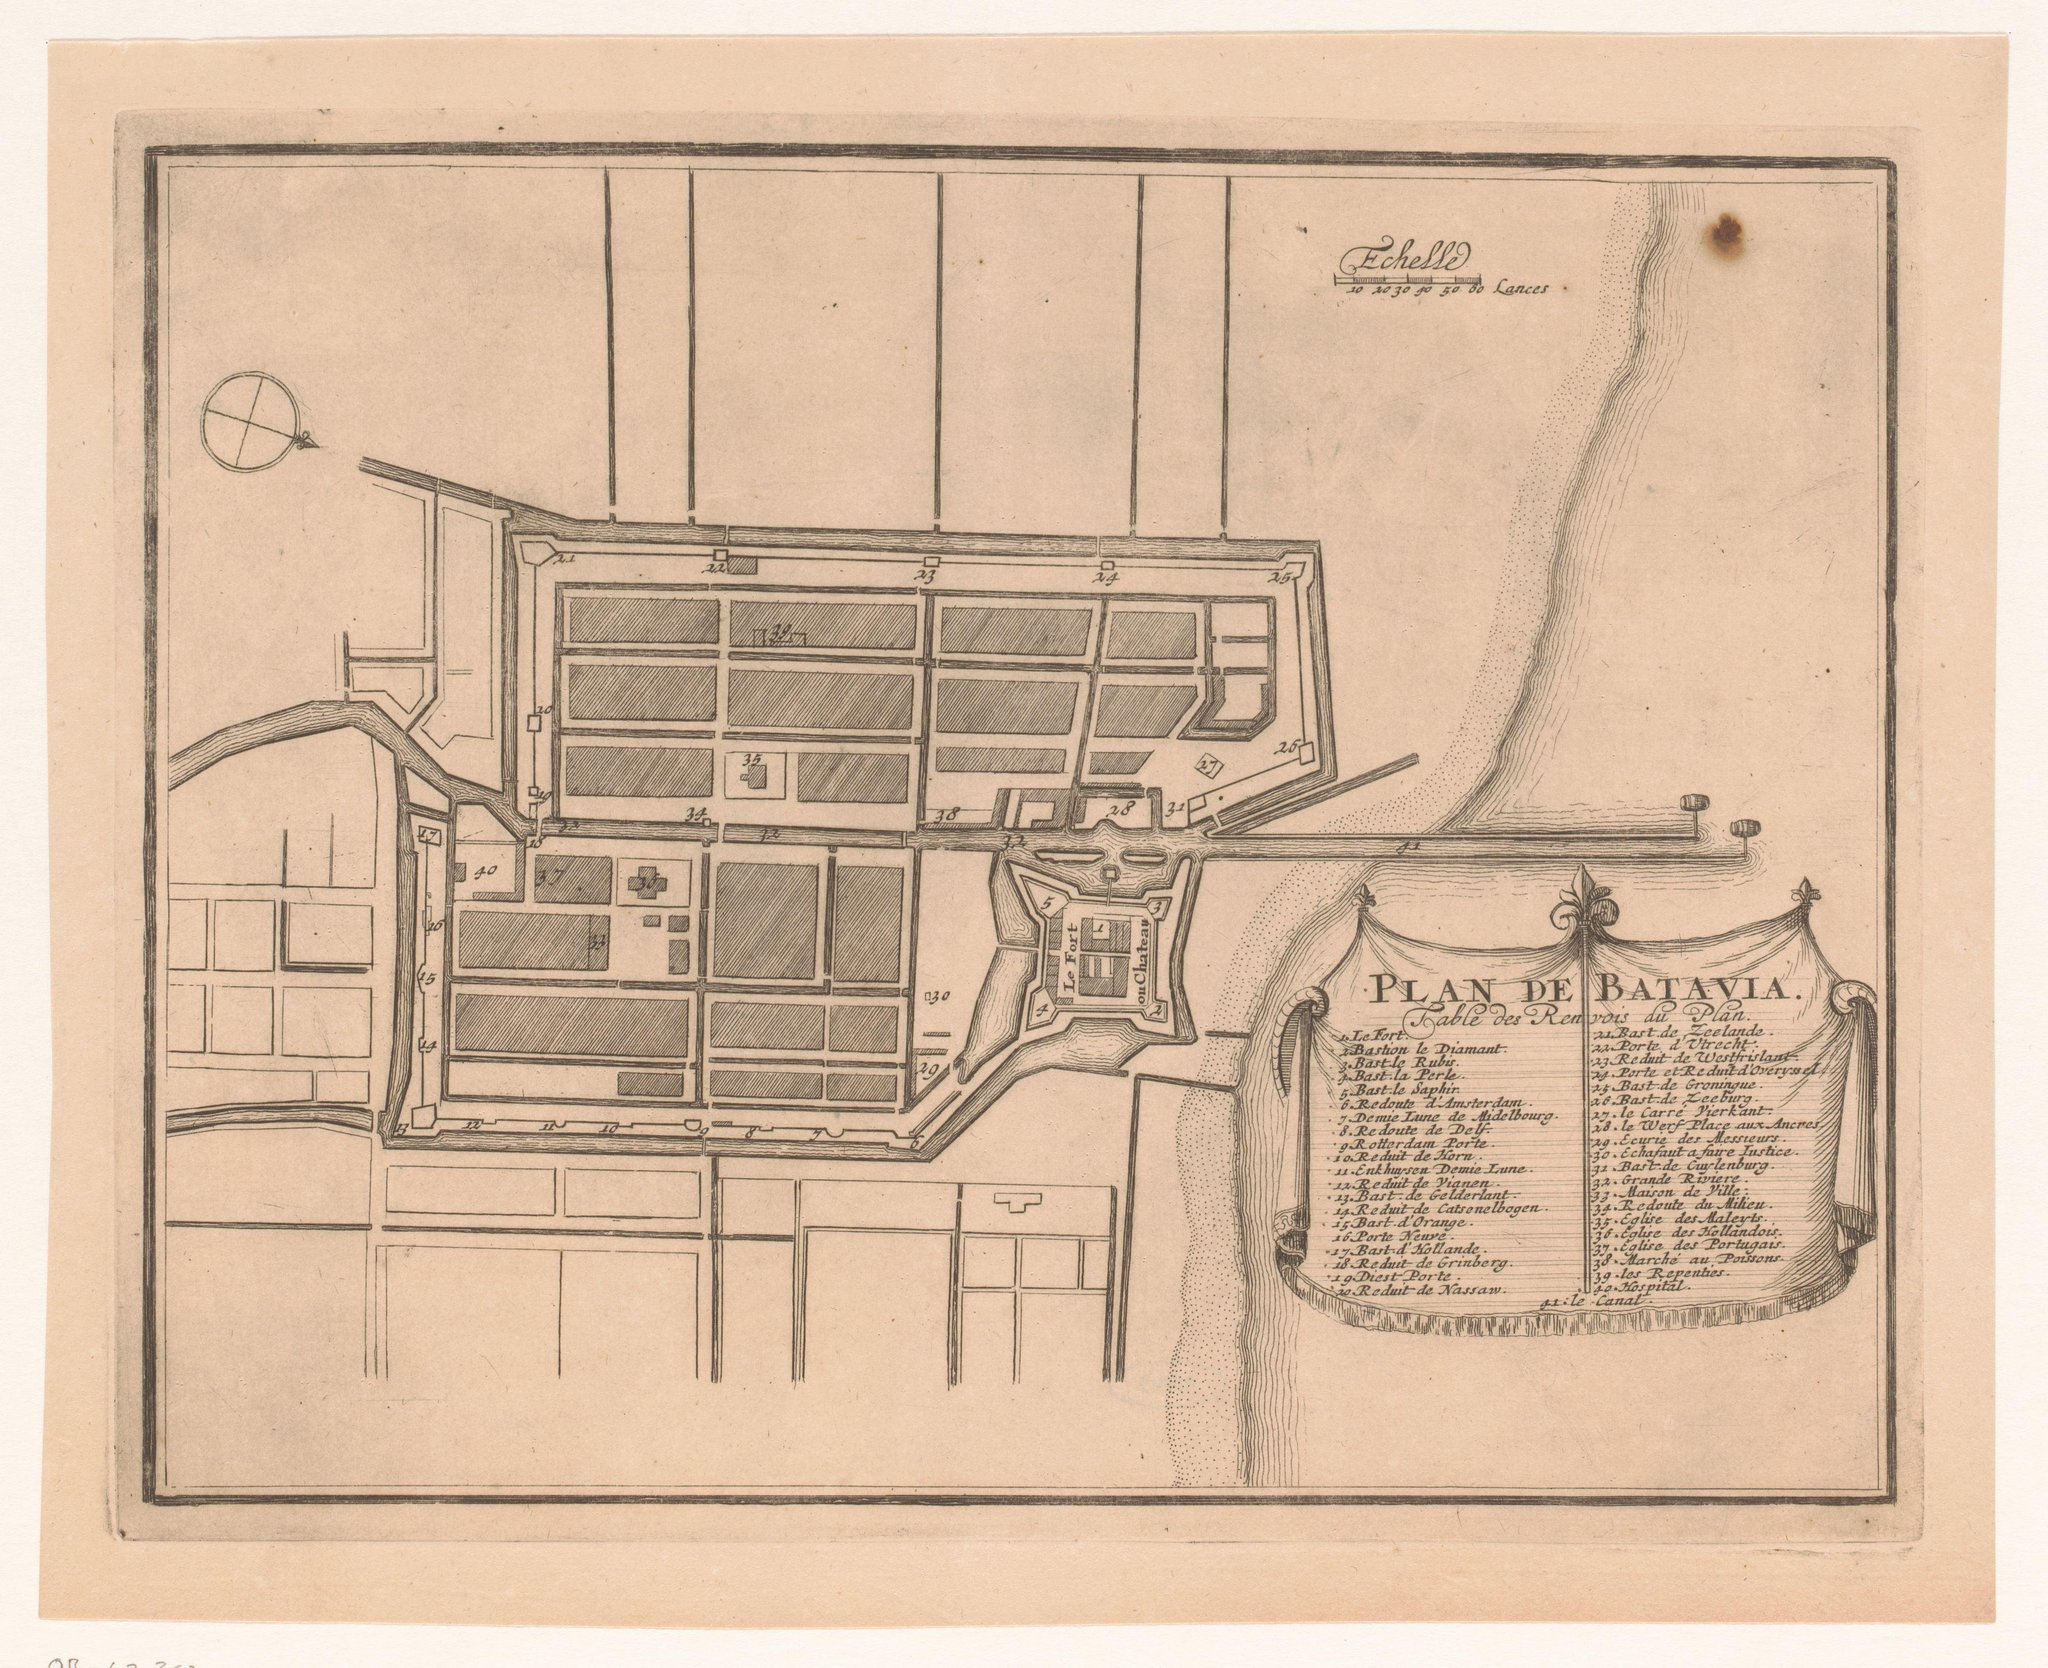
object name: book illustration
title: Les forces de l'Europe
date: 1696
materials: paper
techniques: engraving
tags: maps of cities, batavia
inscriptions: collector's mark: Lugt 2228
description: Prent uit: Fer, Nicolas de. Les forces de l'Europe, ou description des principales villes, avec leurs fortifications (...). 8 dln. Parijs: Nicolas de Fer, 1695-97, dl. 7.